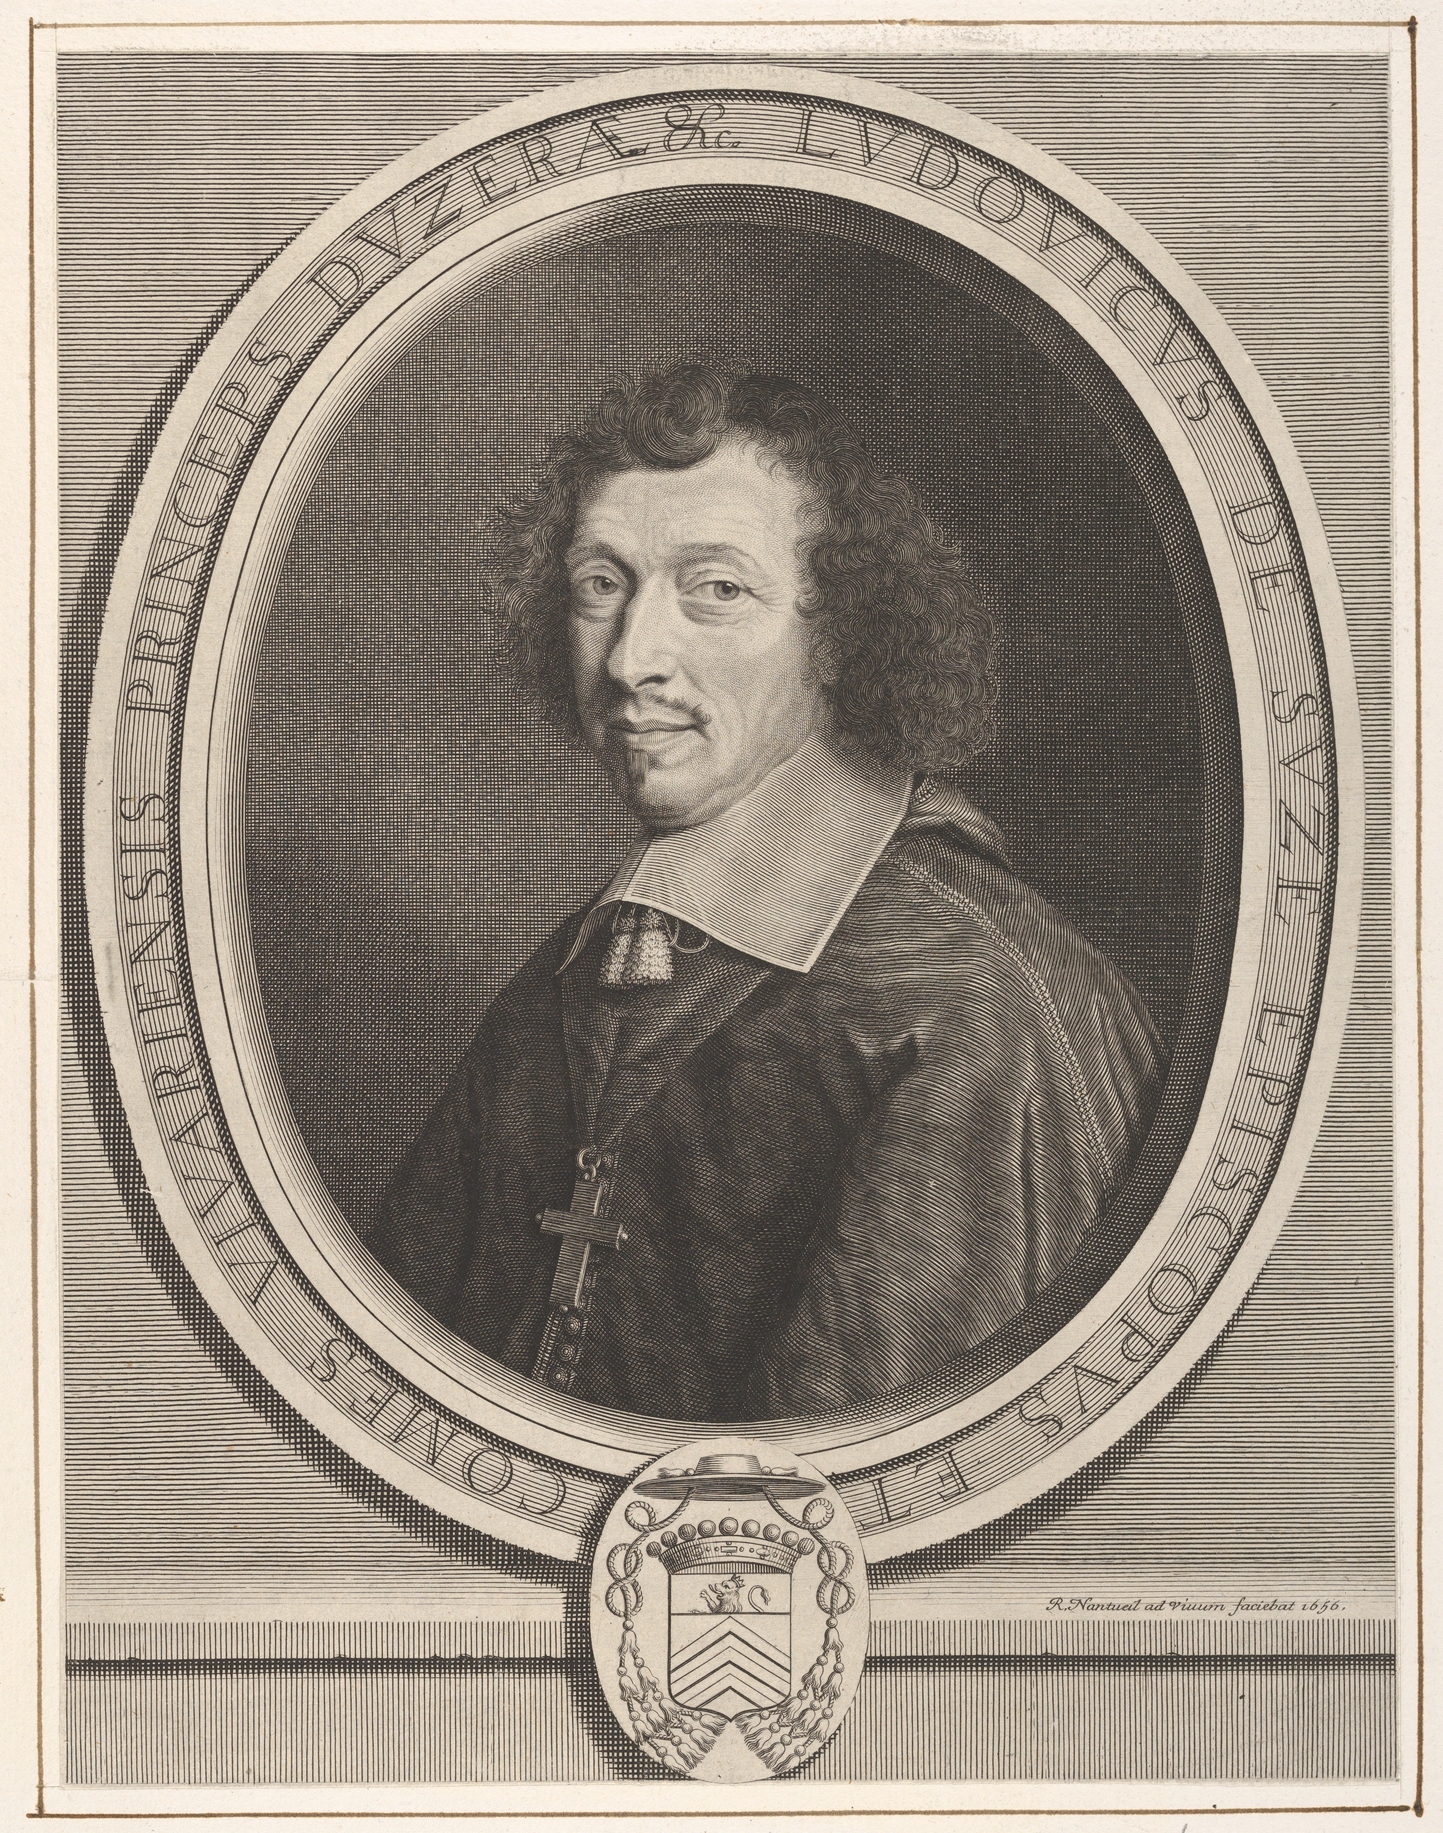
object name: print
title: Louis-François de la Baume de Suze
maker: robert nanteuil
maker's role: artist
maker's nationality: french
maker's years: 1623-1678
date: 1656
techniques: engraving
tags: men,portraits,cross